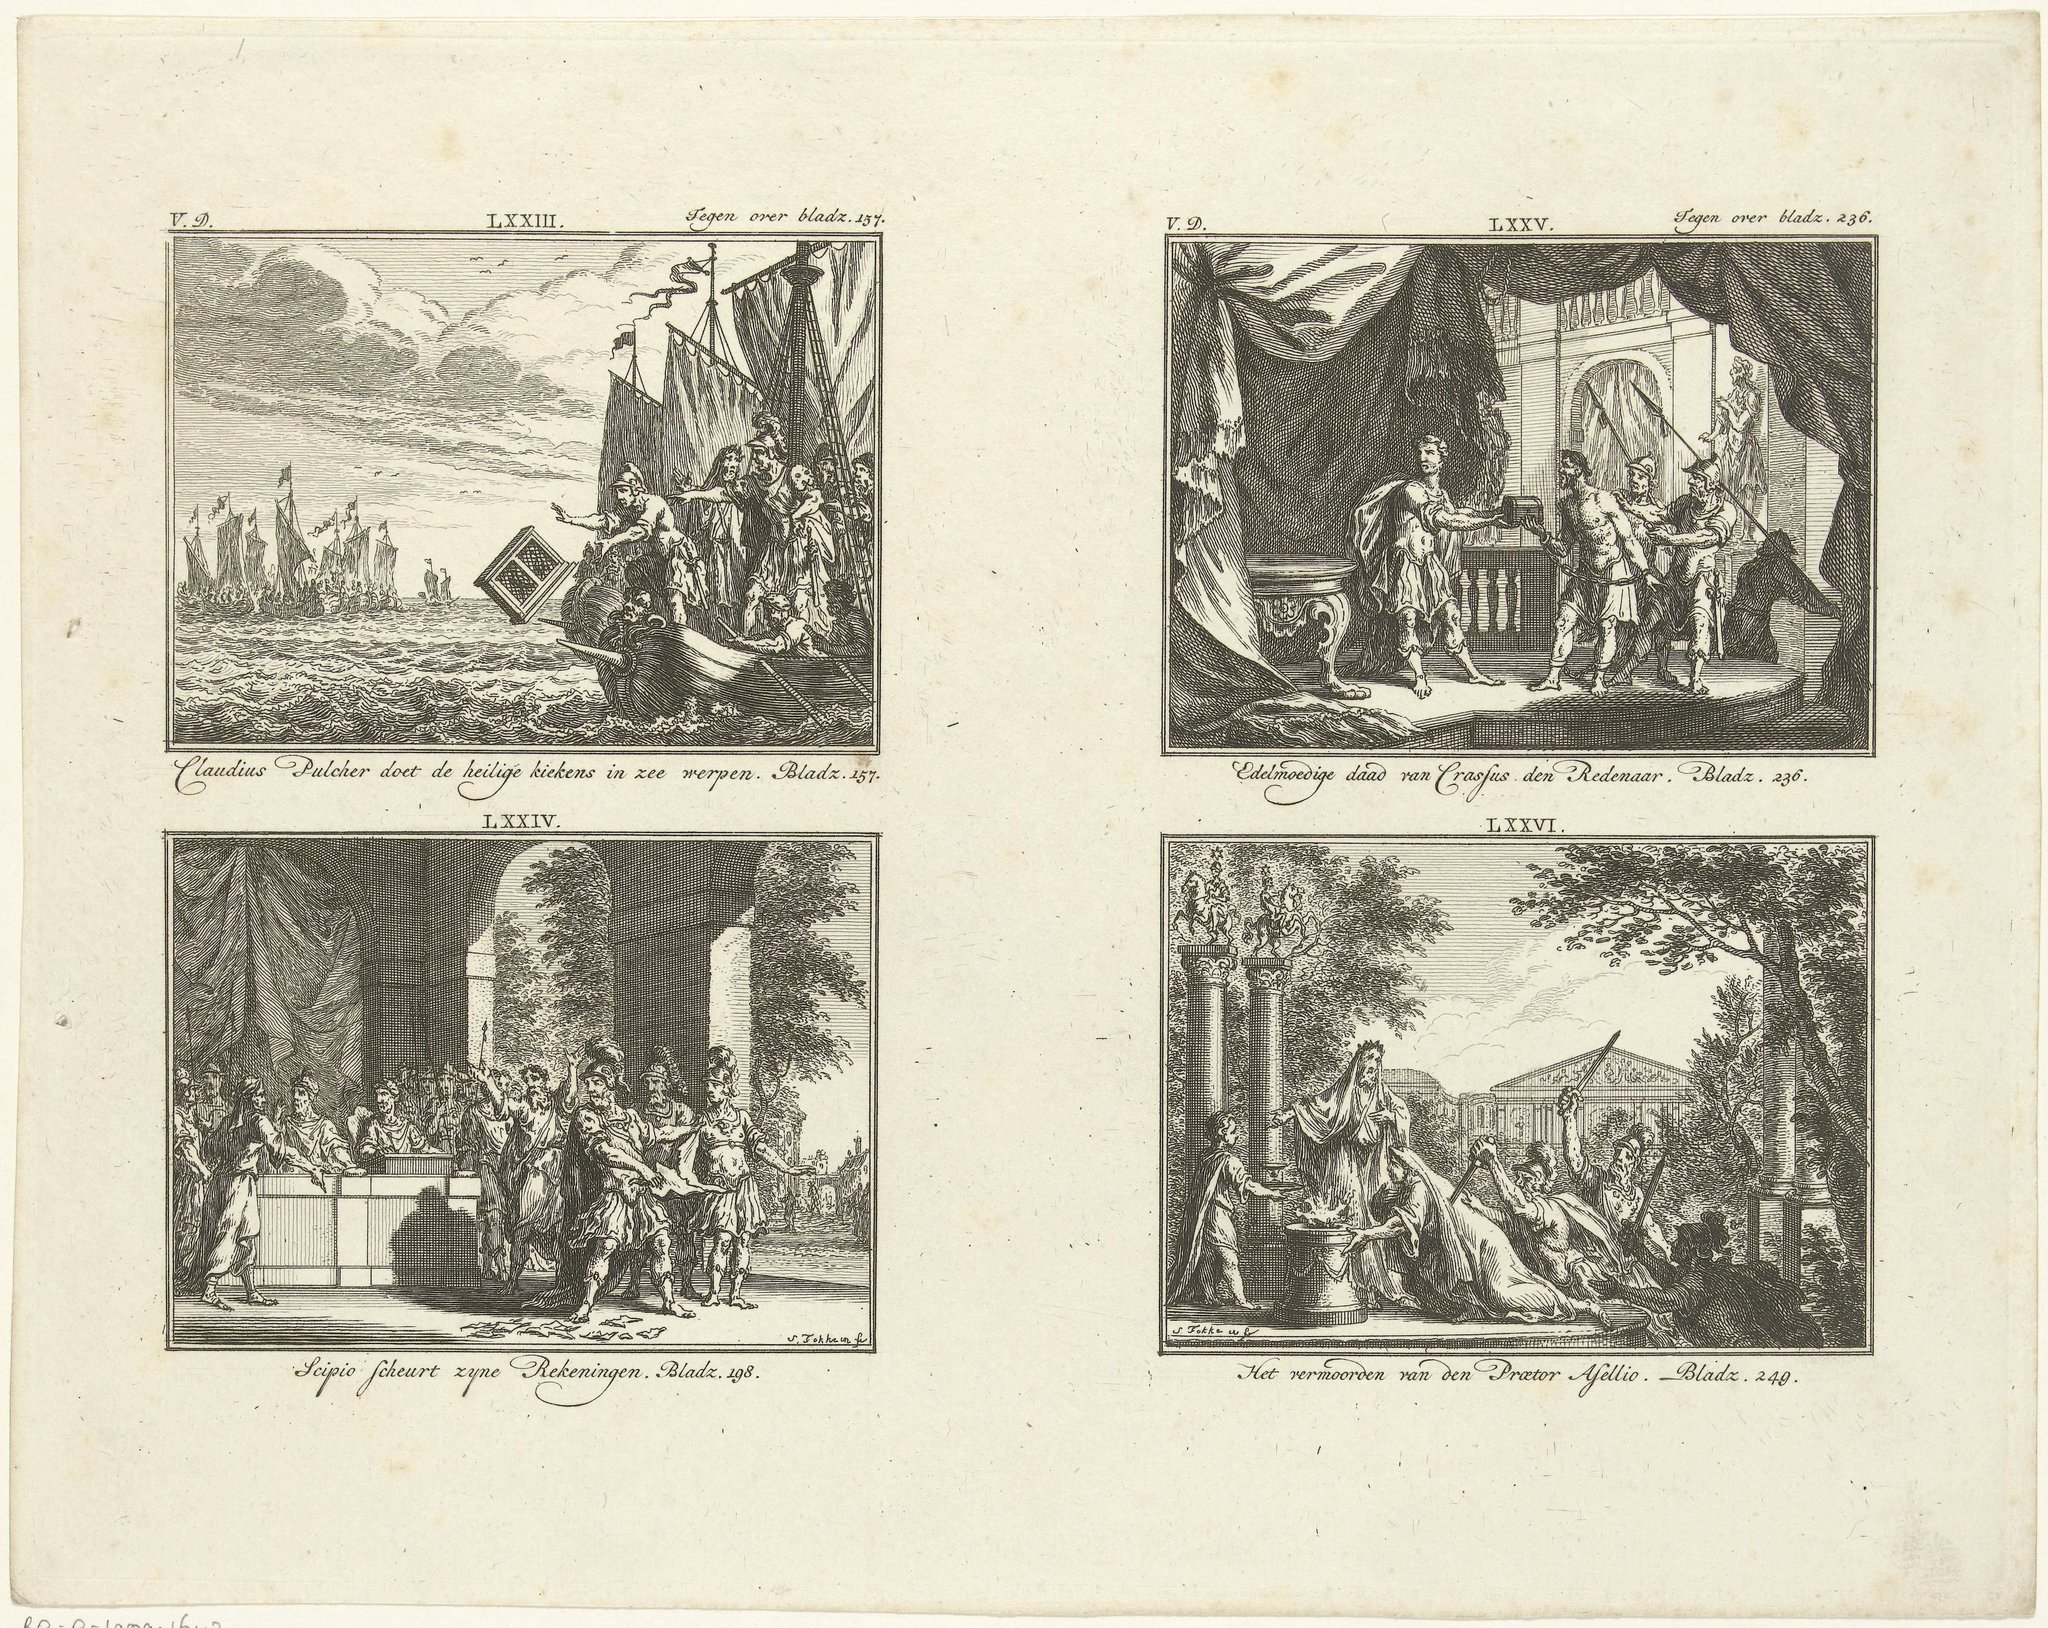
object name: print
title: Vier voorstellingen uit de klassieke geschiedenis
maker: simon fokke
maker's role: draughtsman, print maker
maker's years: 1712-1784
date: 1722-1784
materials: paper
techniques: etching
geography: amsterdam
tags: murder, (story of) m. licinius crassus, scipio, accused of extortion, silences his accusers by tearing up the bills and leading the people to the capitol to thank the gods for his victory over hannibal, (story of) publius clodius (claudius) pulcher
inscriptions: collector's mark: Lugt 2228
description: Vier voorstellingen uit de klassieke geschiedenis van één plaat, genummerd van LXXIII tot en met LXXVI en alle voorzien van een onderschrift. Linksboven: Claudius Pulcher gooit kippen in zee. Linksonder: Scipio verscheurt de rekeningen. Rechtsboven: Edelmoedige daad van Crassus. Rechtsonder: Moord op de praetor Asellio. Voorstellingen LXXIII en LXXIV rechtsboven gemerkt: Tegen over bladz. 137. Voorstellingen LXXV en LXXVI rechtsboven gemerkt: Tegen over bladz. 236.